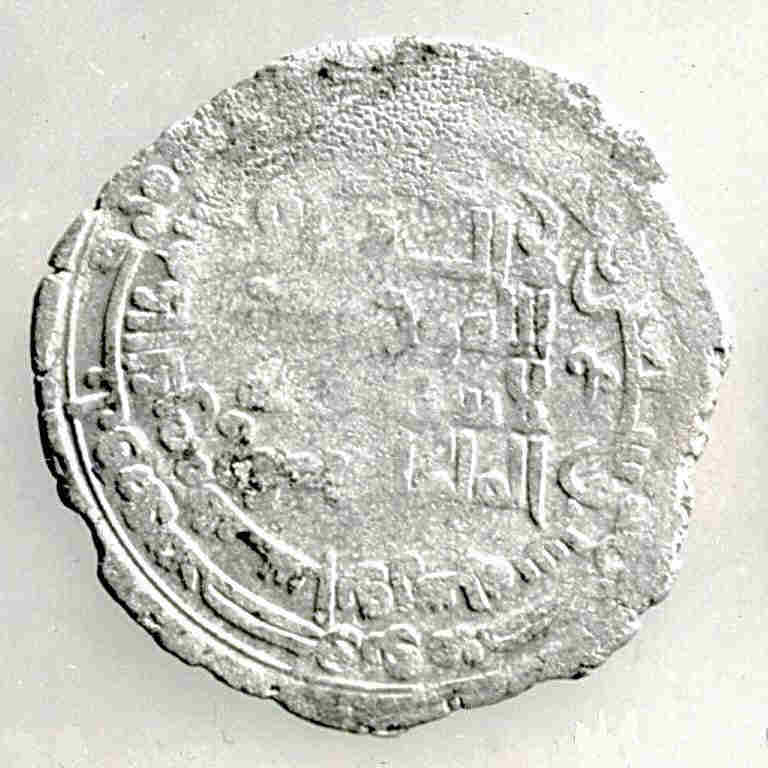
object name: coin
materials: silver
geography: iran